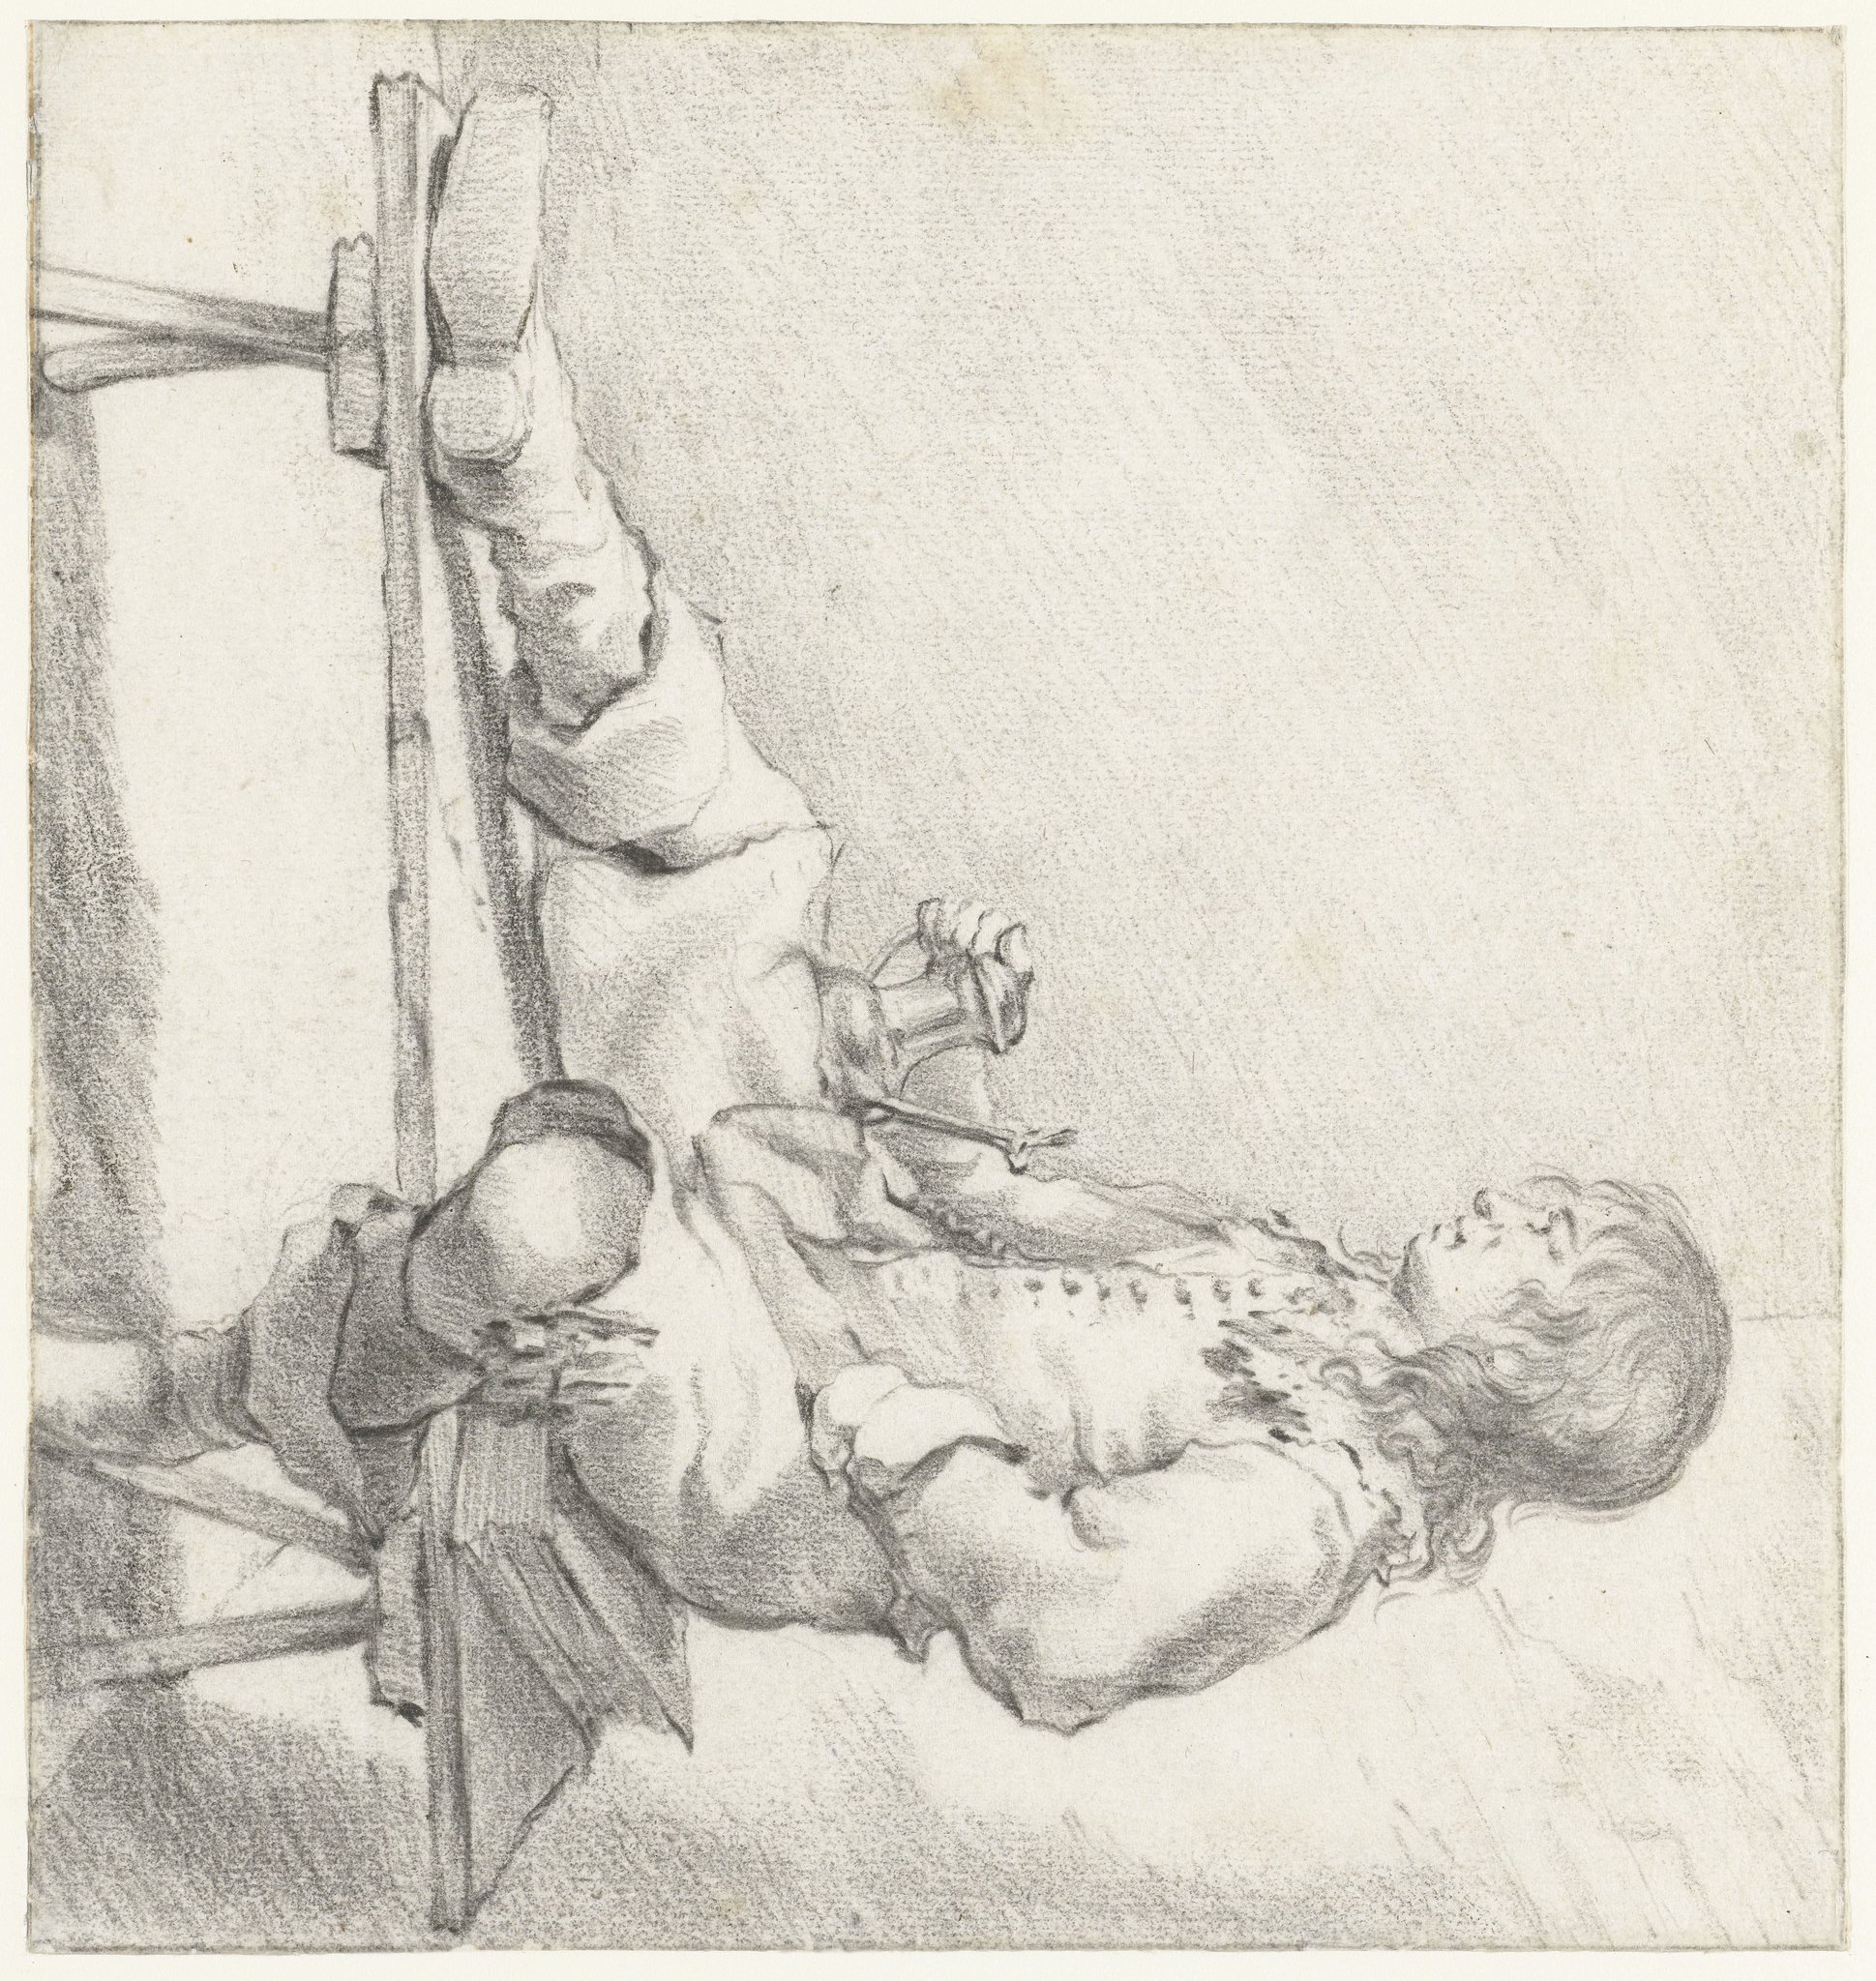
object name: drawing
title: Young Man Seated on a Book on a Bench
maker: constantijn verhout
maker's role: draughtsman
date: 1650-1660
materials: chalk, paper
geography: gouda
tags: sitting figure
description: Jongeman op een bankje, zittend op een boek met een tinnen kruik in de rechterhand.